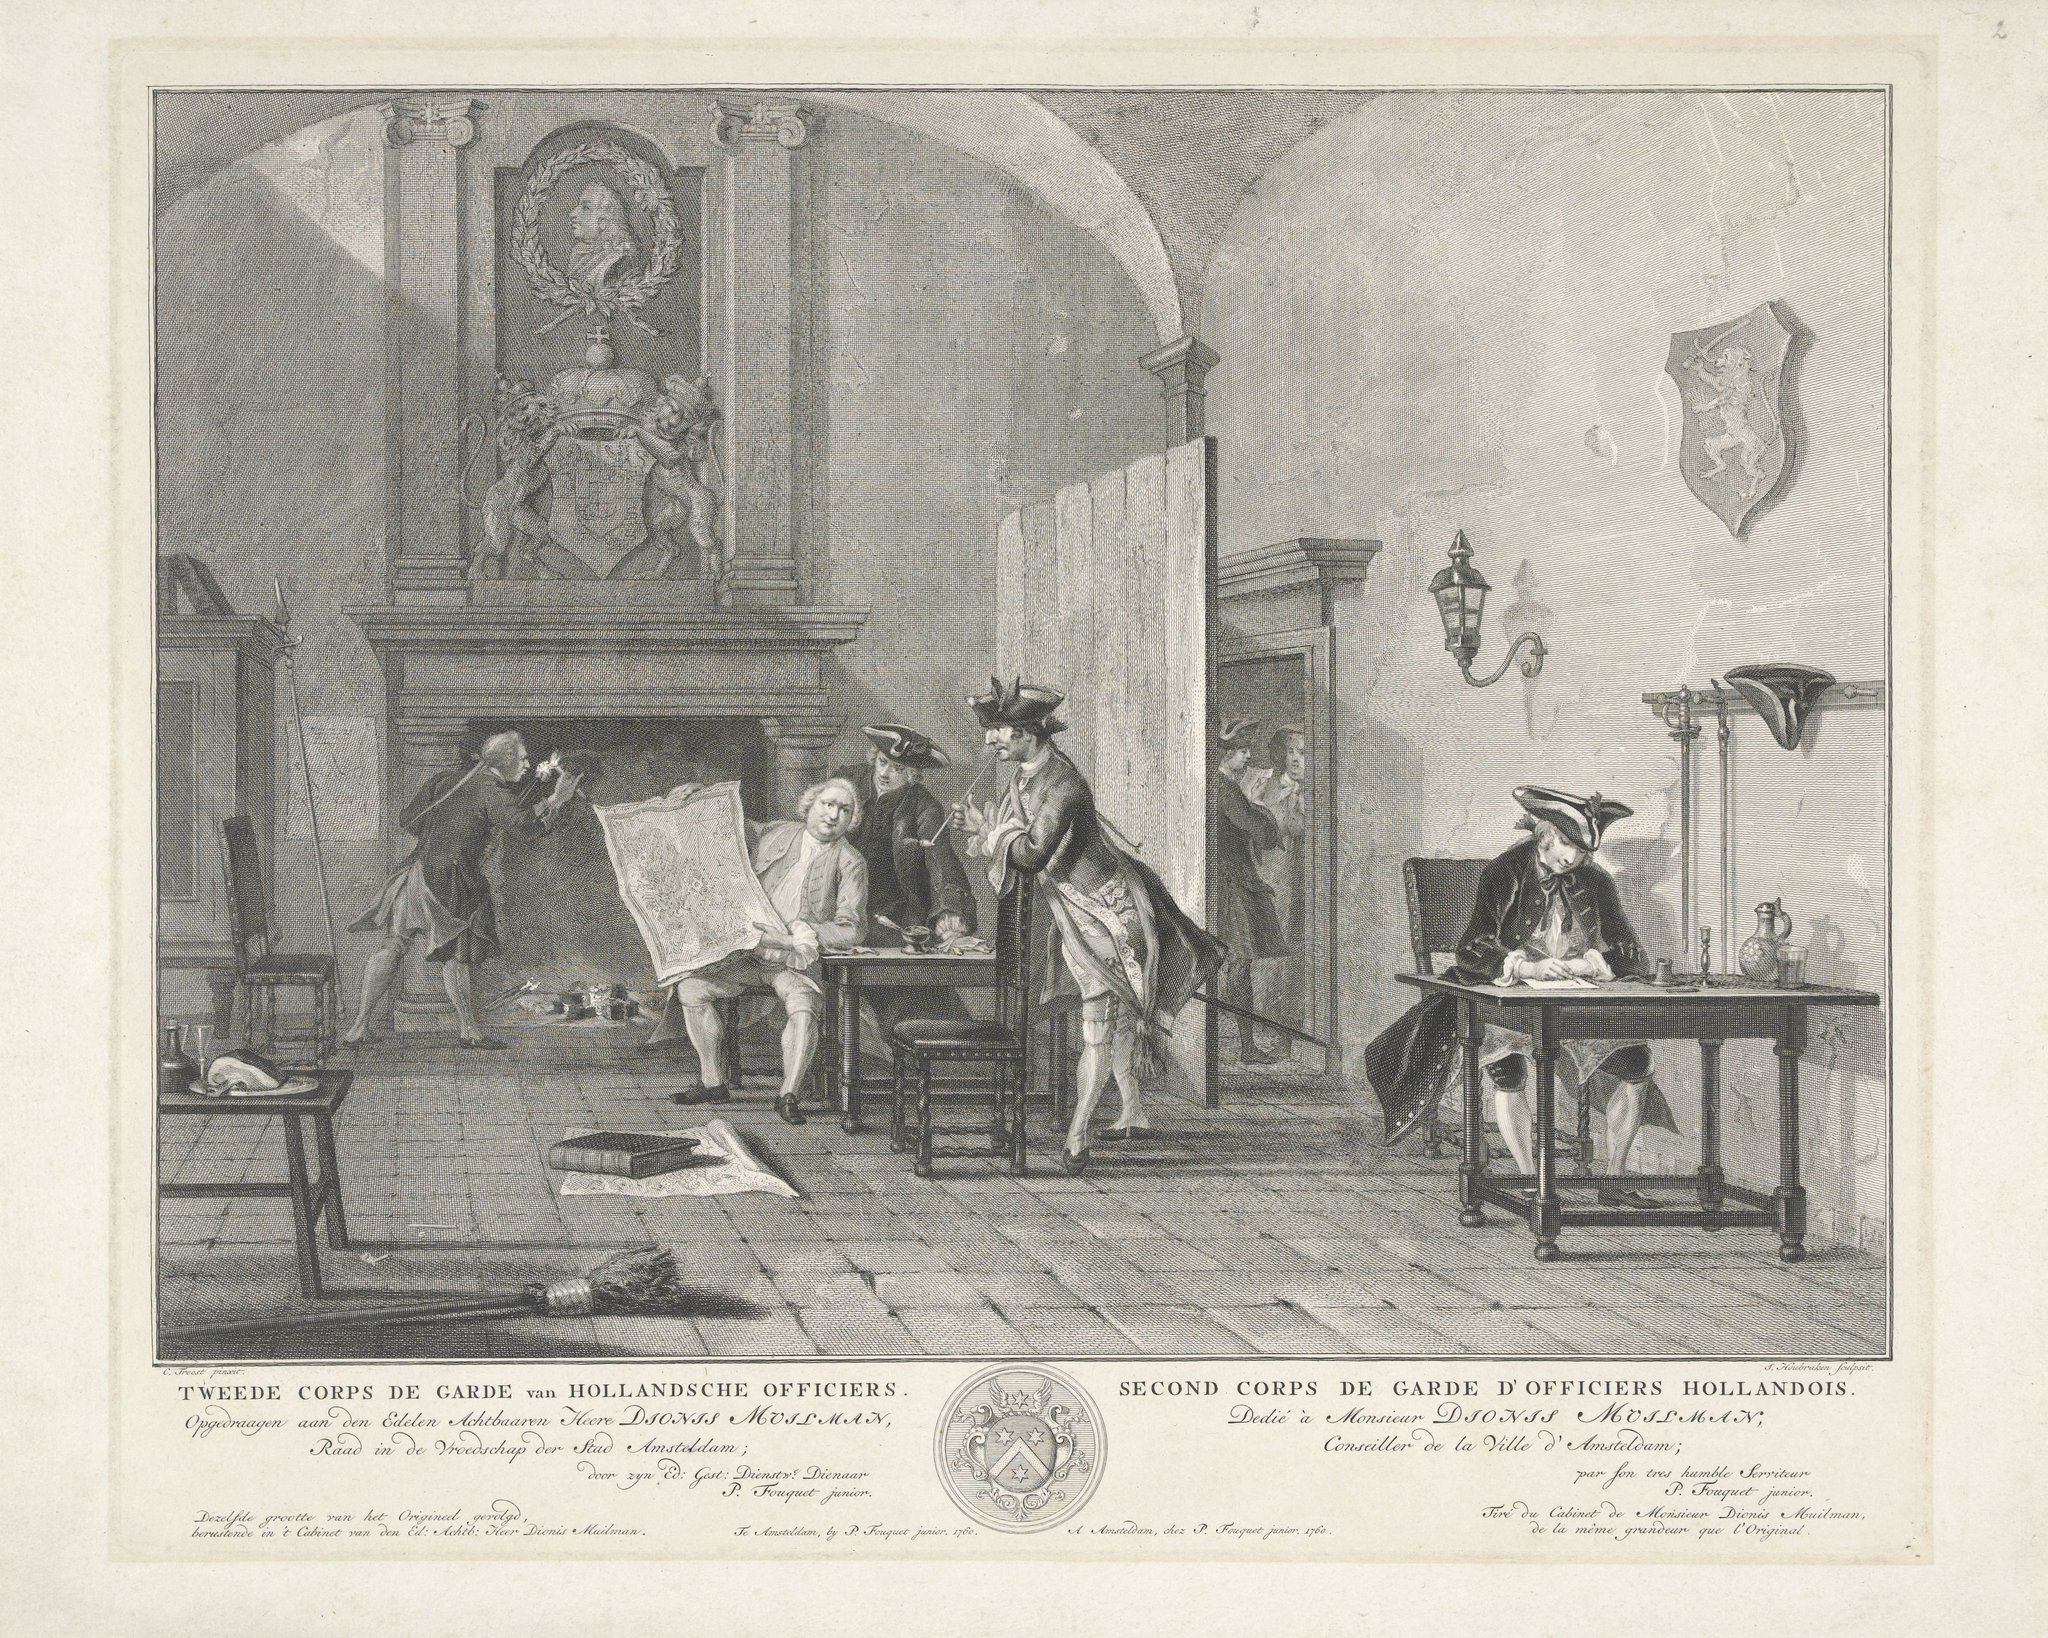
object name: print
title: Tweede corps de garde van Hollandsche officiers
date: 1760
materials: paper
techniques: engraving, etching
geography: amsterdam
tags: open hearth, fire-place, handwriting, written text, studying a map, meeting of soldiers and/or officers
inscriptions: collector's mark: Lugt 240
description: Een interieur met verschillende officieren. Rechts zit een man aan een schrijftafel, links is een man bezig met vuur uit de open haard, in het midden kijken drie heren op een kaart. Boven de schoorsteen een wapenschild en daarboven een een met een lauwerkrans omgeven portret van een man en profil.